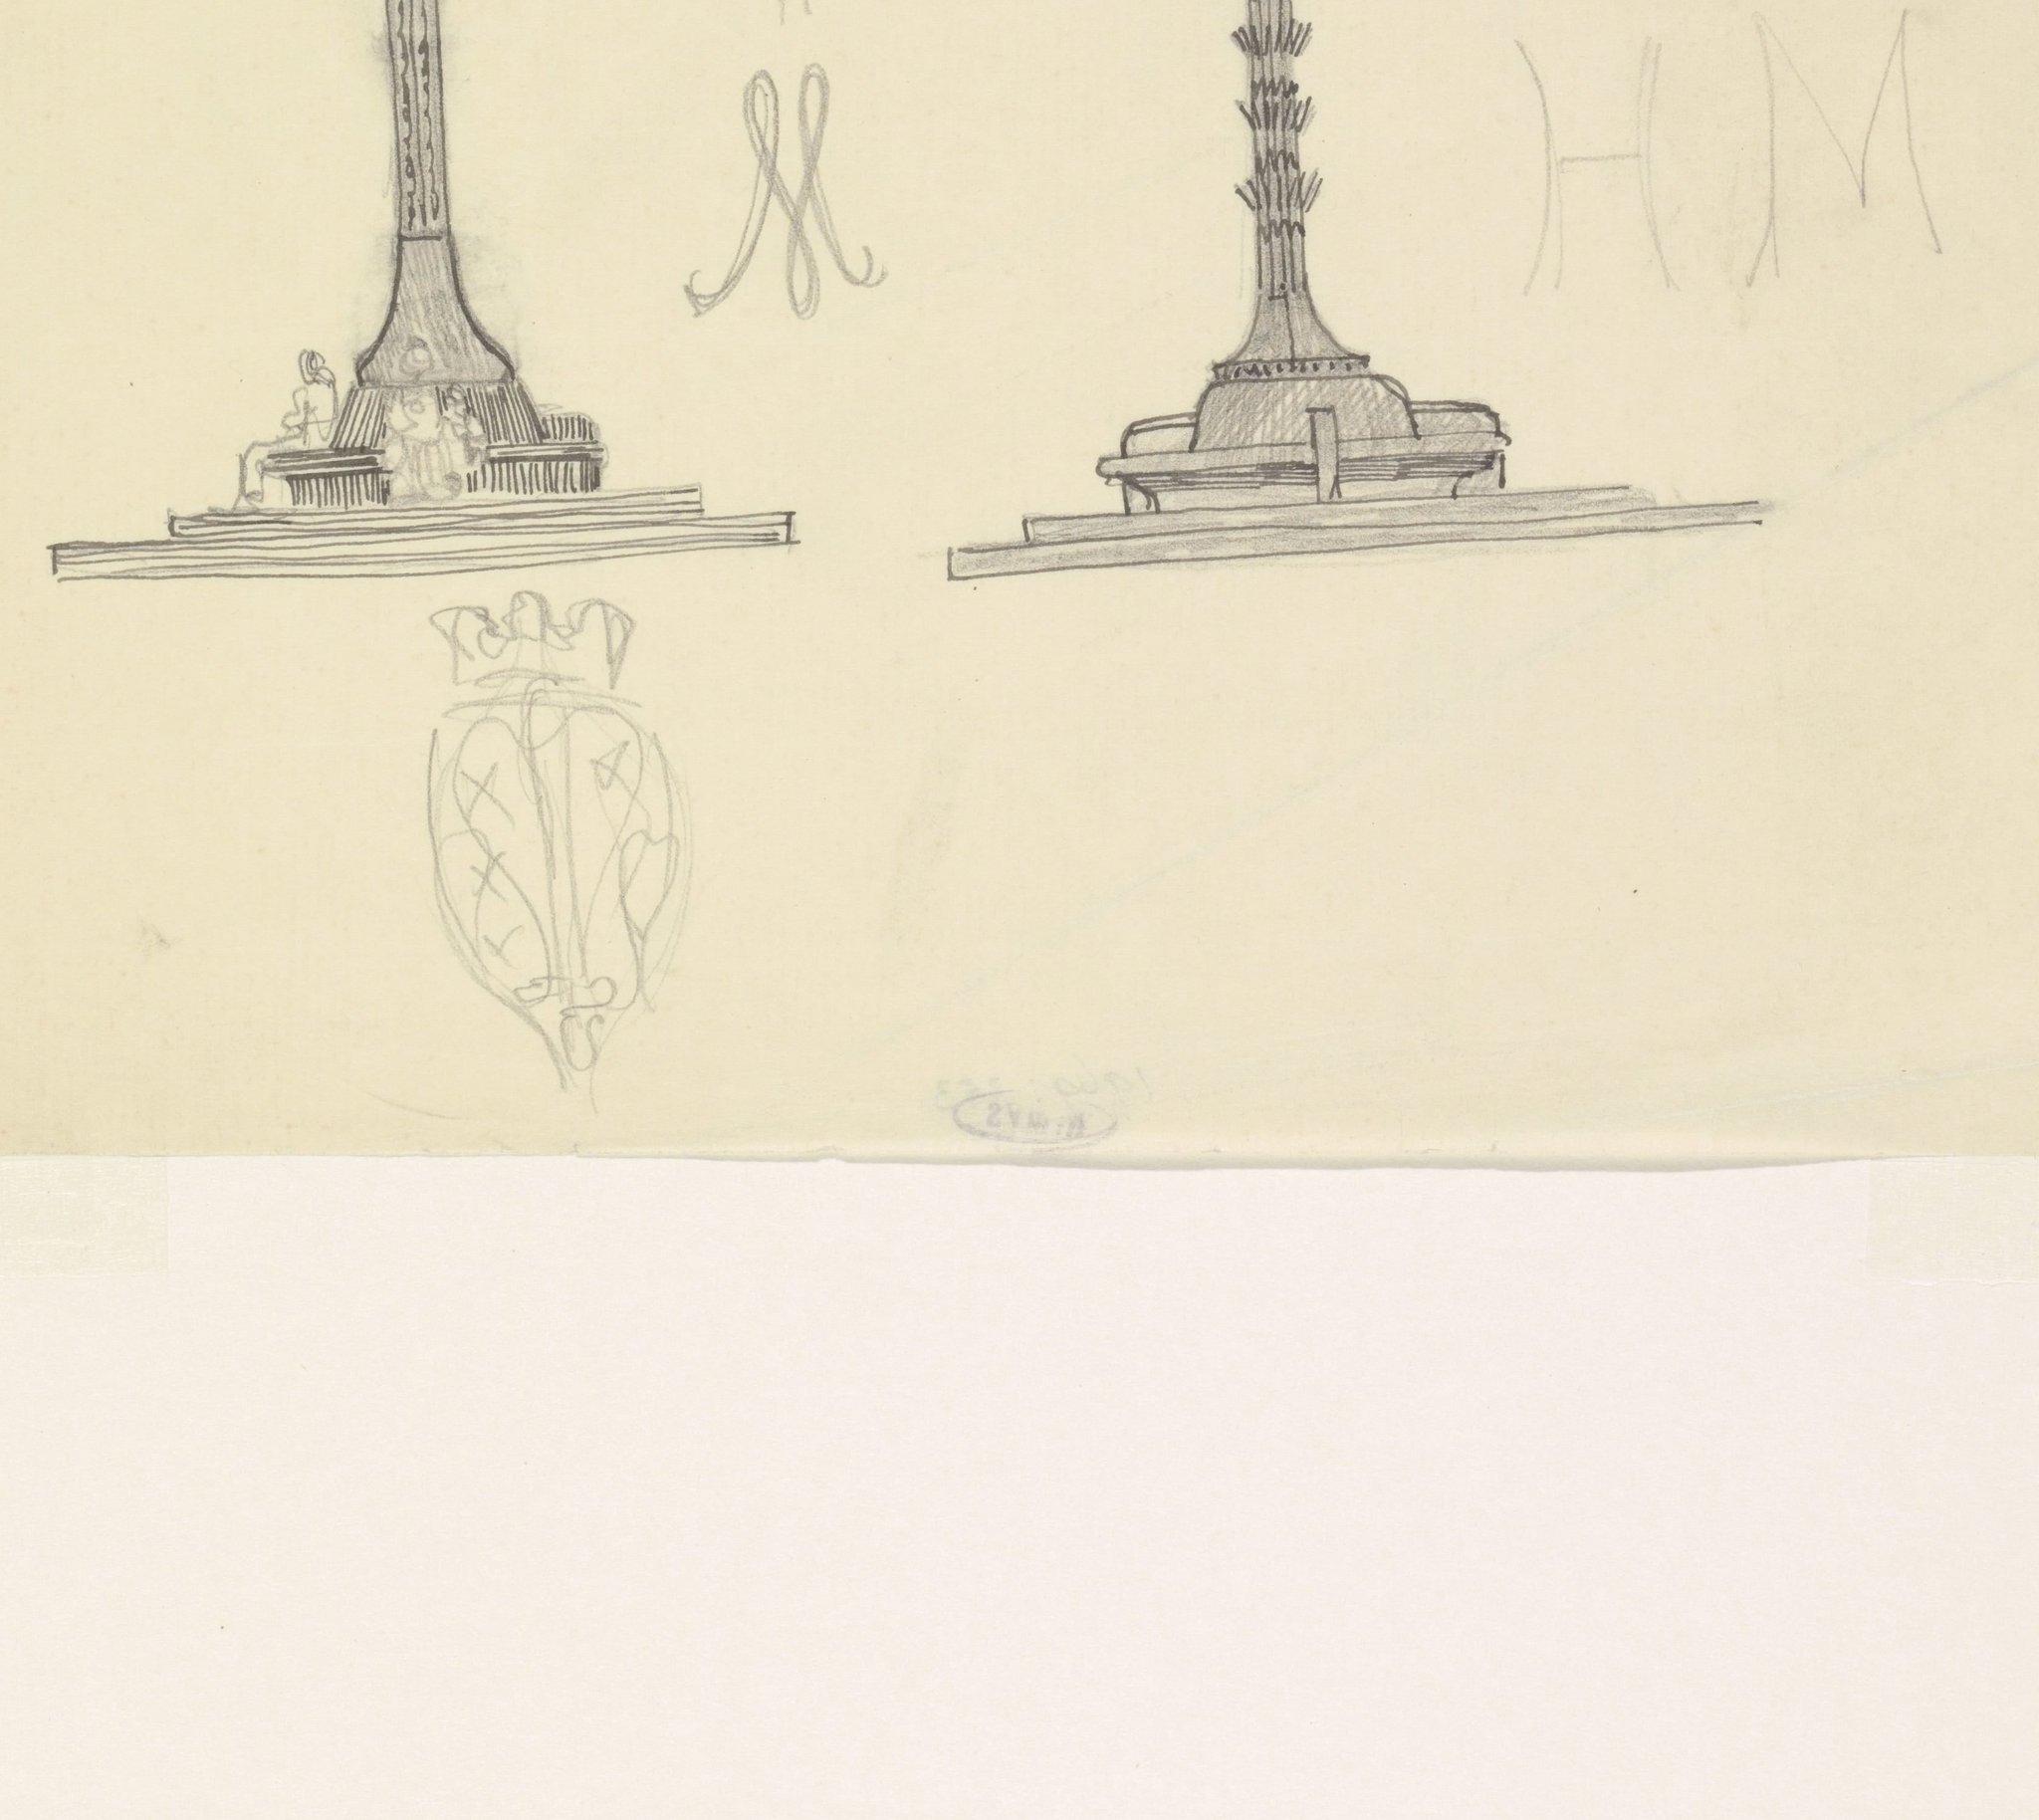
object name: drawing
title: Ontwerpen voor een monument met bank en het wapen van Haarlem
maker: carel adolph lion cachet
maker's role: draughtsman, print maker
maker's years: 1864-1945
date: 1874-1945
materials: ink, paper, pencil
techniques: pen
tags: bench, coat of arms (as symbol of the state, etc.) (+ city; municipal), work of monumental art, haarlem